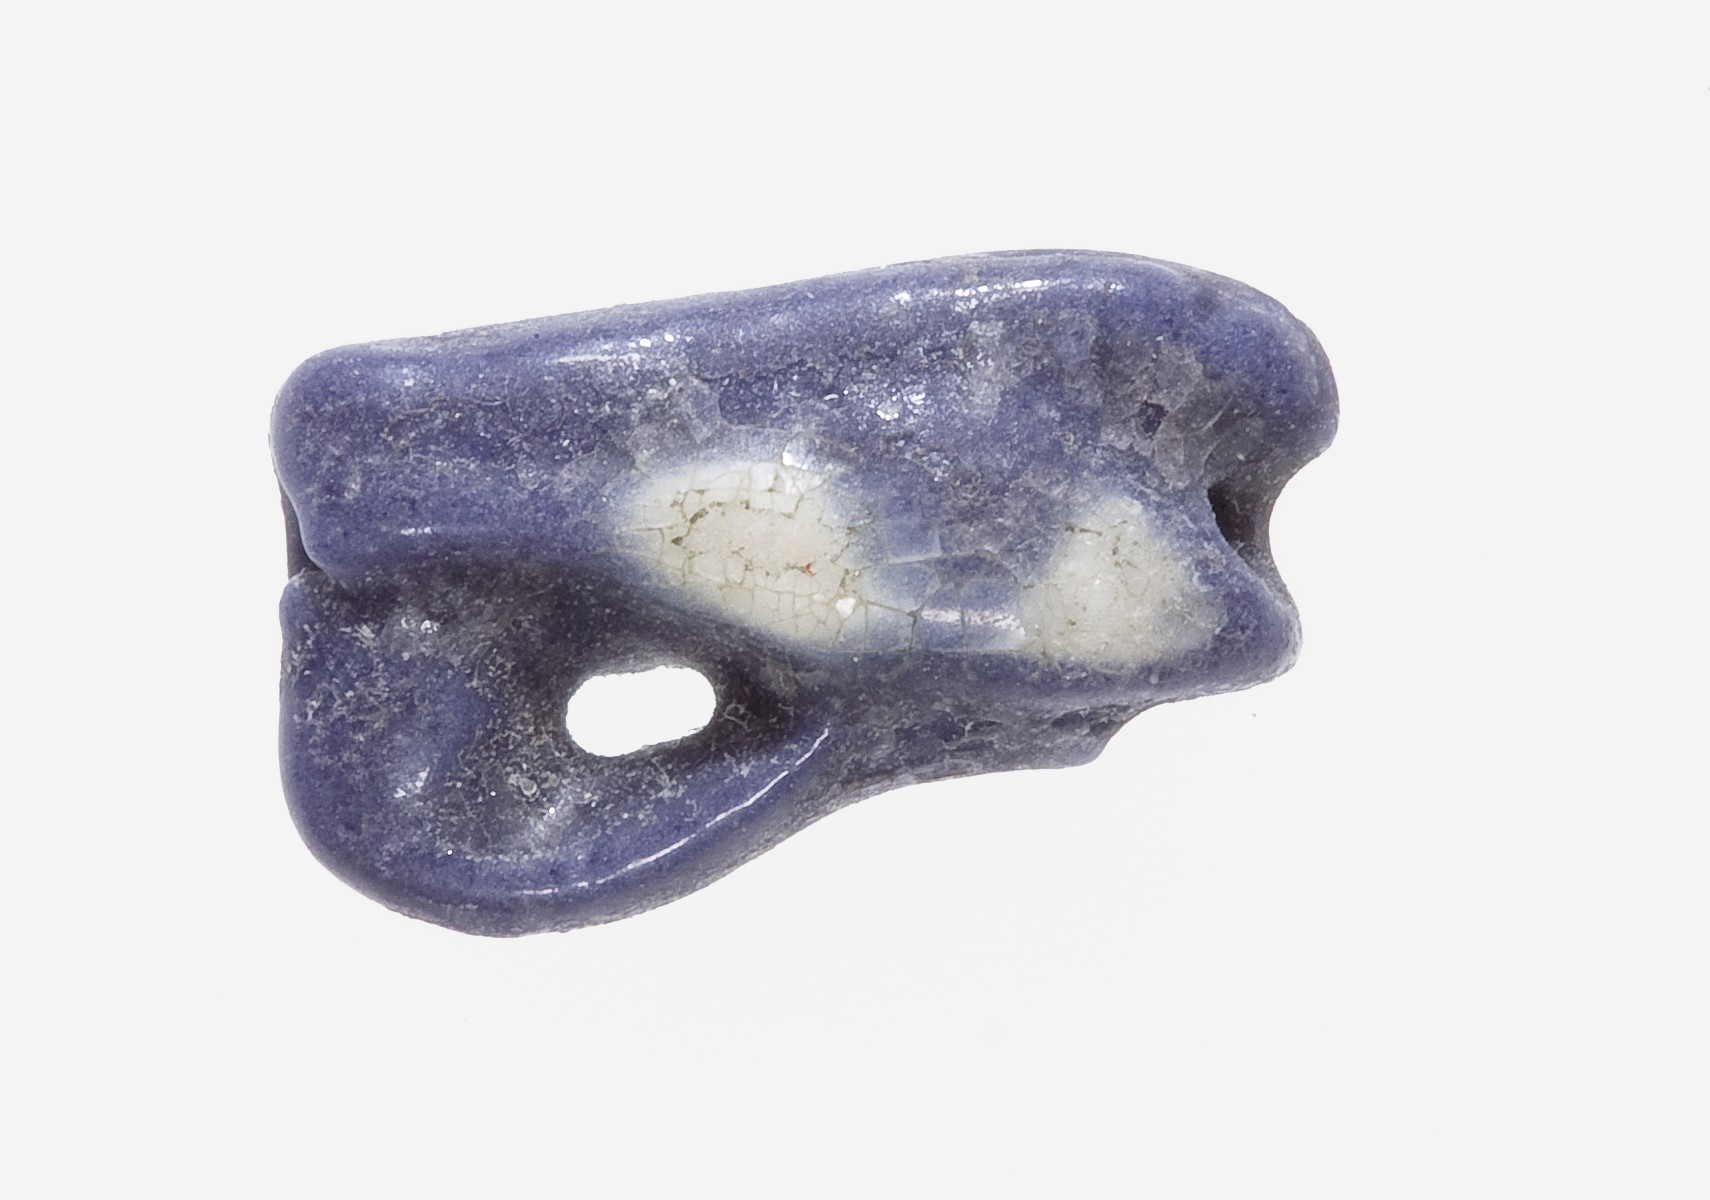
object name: amulet, wedjat eye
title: Sacred Eye Amulet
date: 1390-1352 BCE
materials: faience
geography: egypt